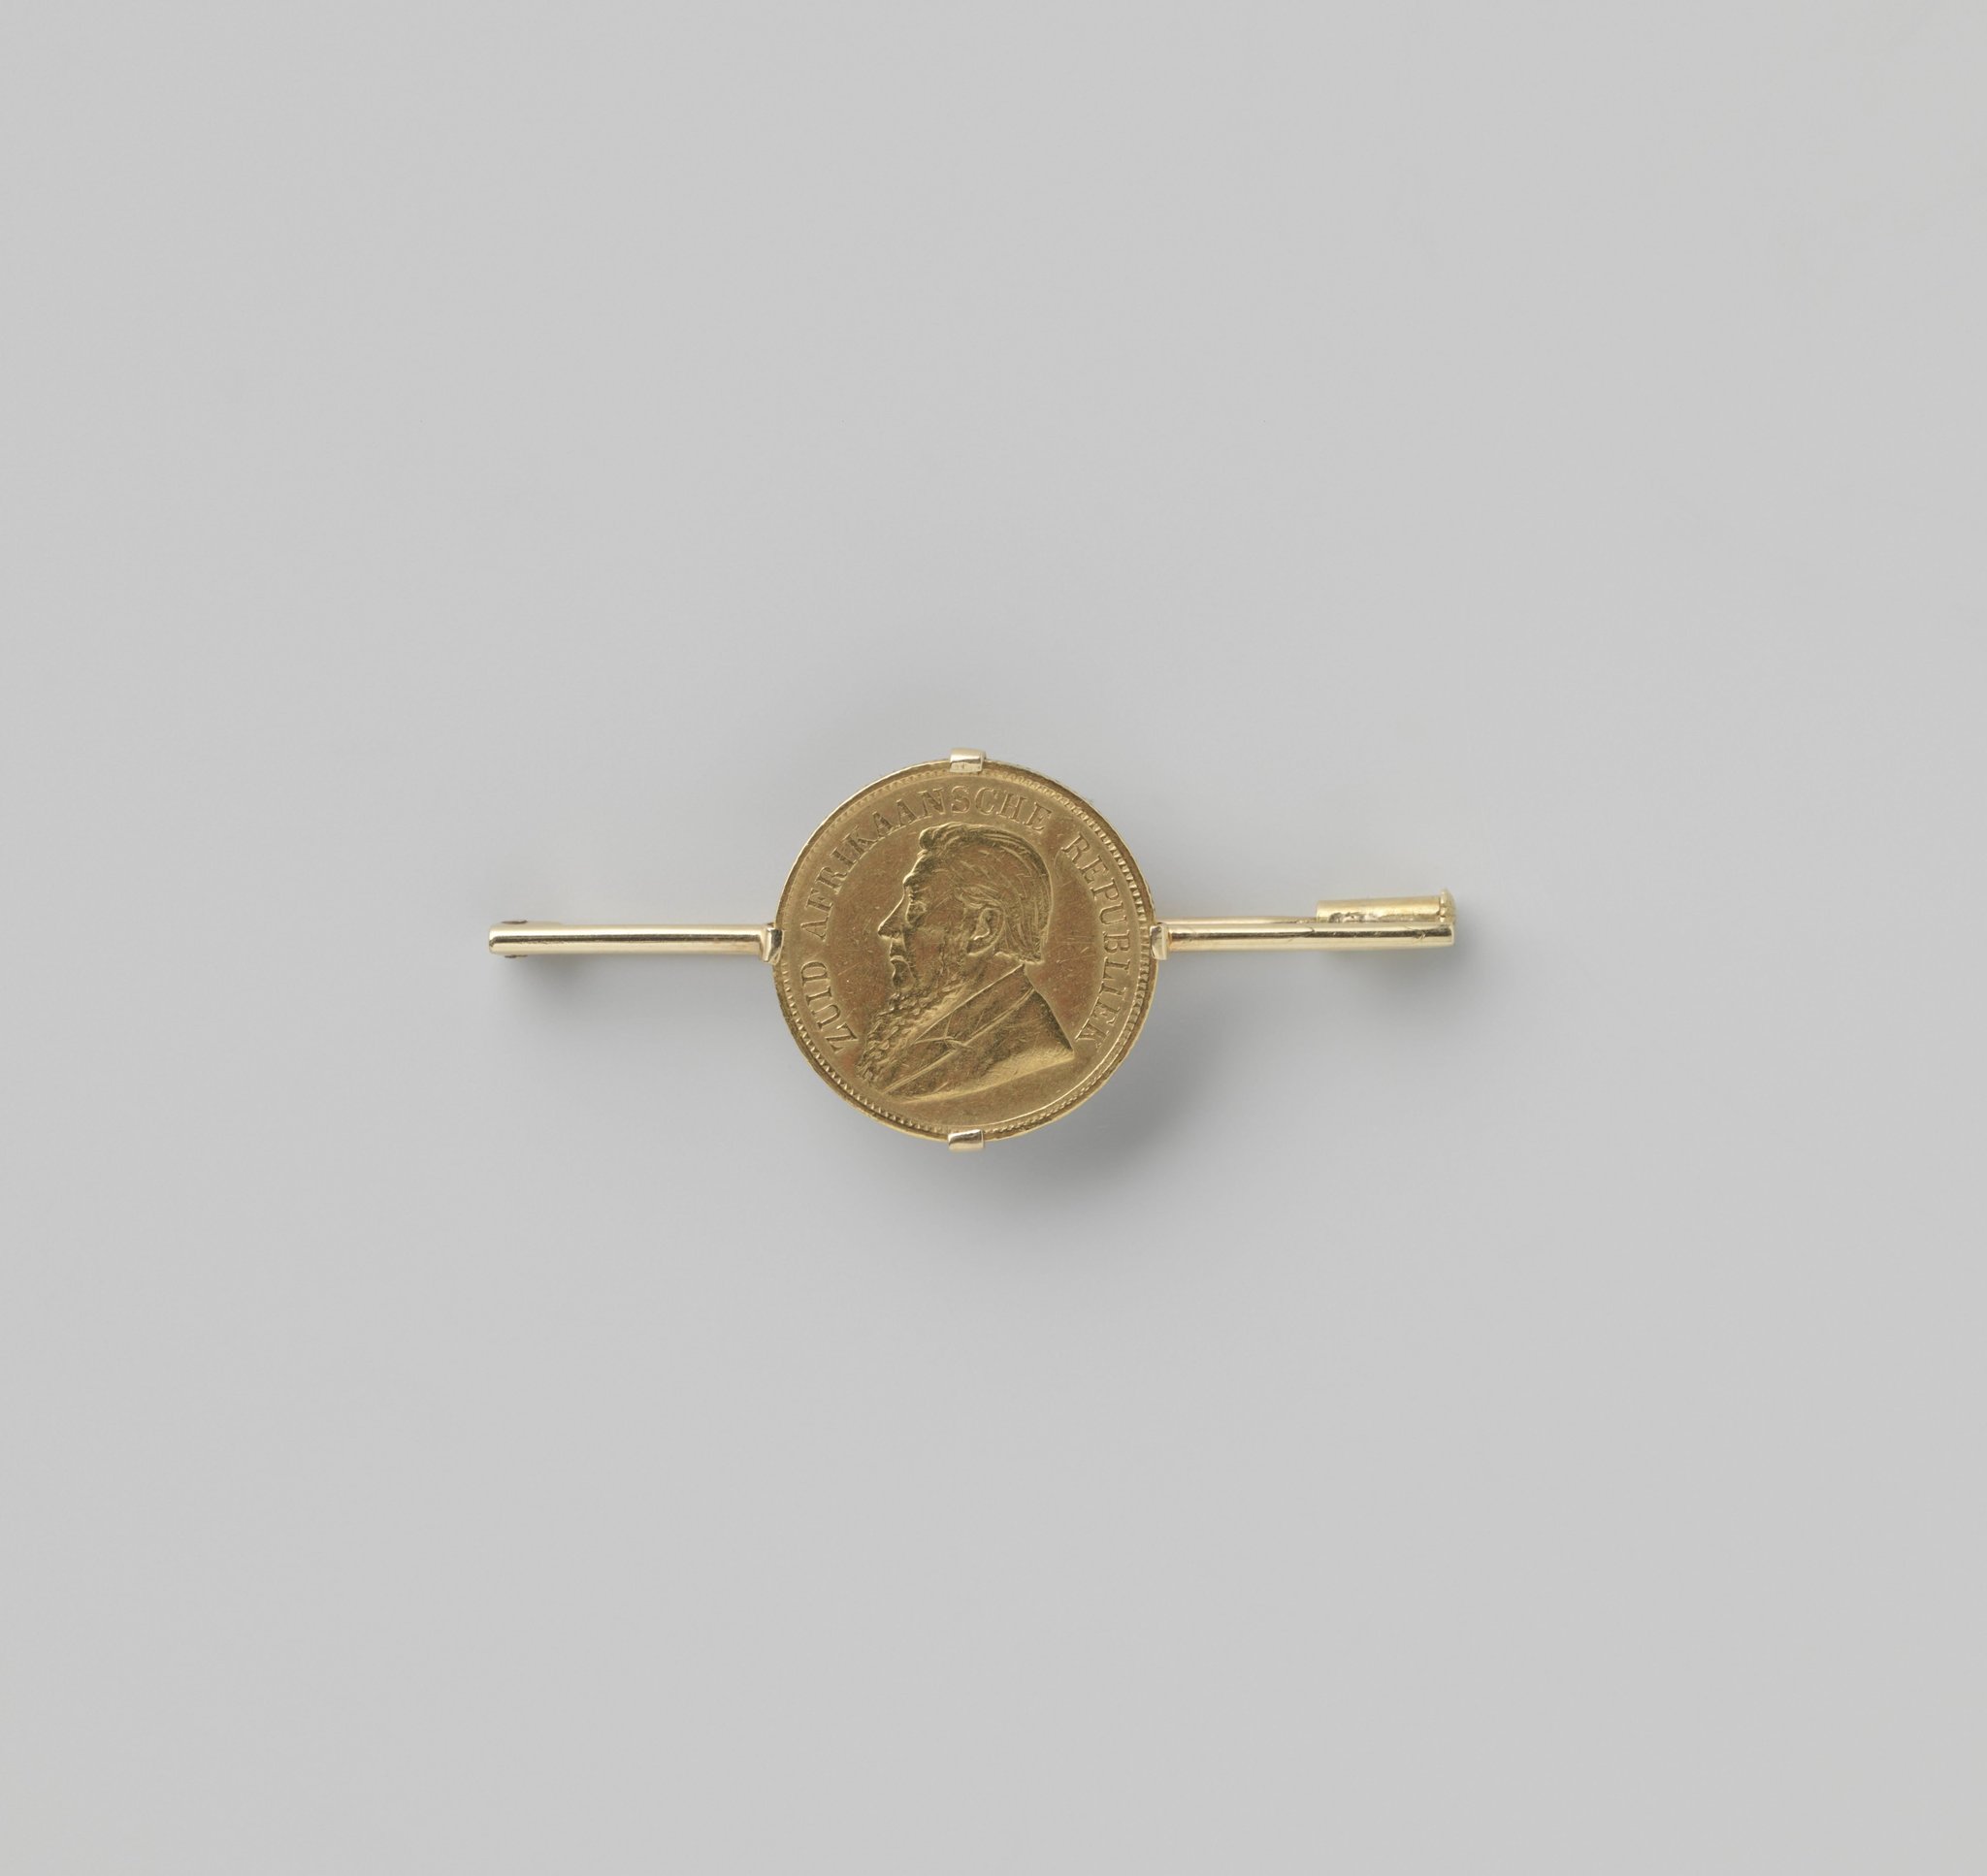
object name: brooch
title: Brochette van goud met een halve pond uit 1897 met de beeldenaar van Paul Krüger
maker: Anonymous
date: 1900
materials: gold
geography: south africa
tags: vaalbank, clarens (zuid-afrika), president, paul kruger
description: Brochette van goud met een halve pond uit 1897 met de beeldenaar van Paul Krüger voorzien van een kanonsluiting.